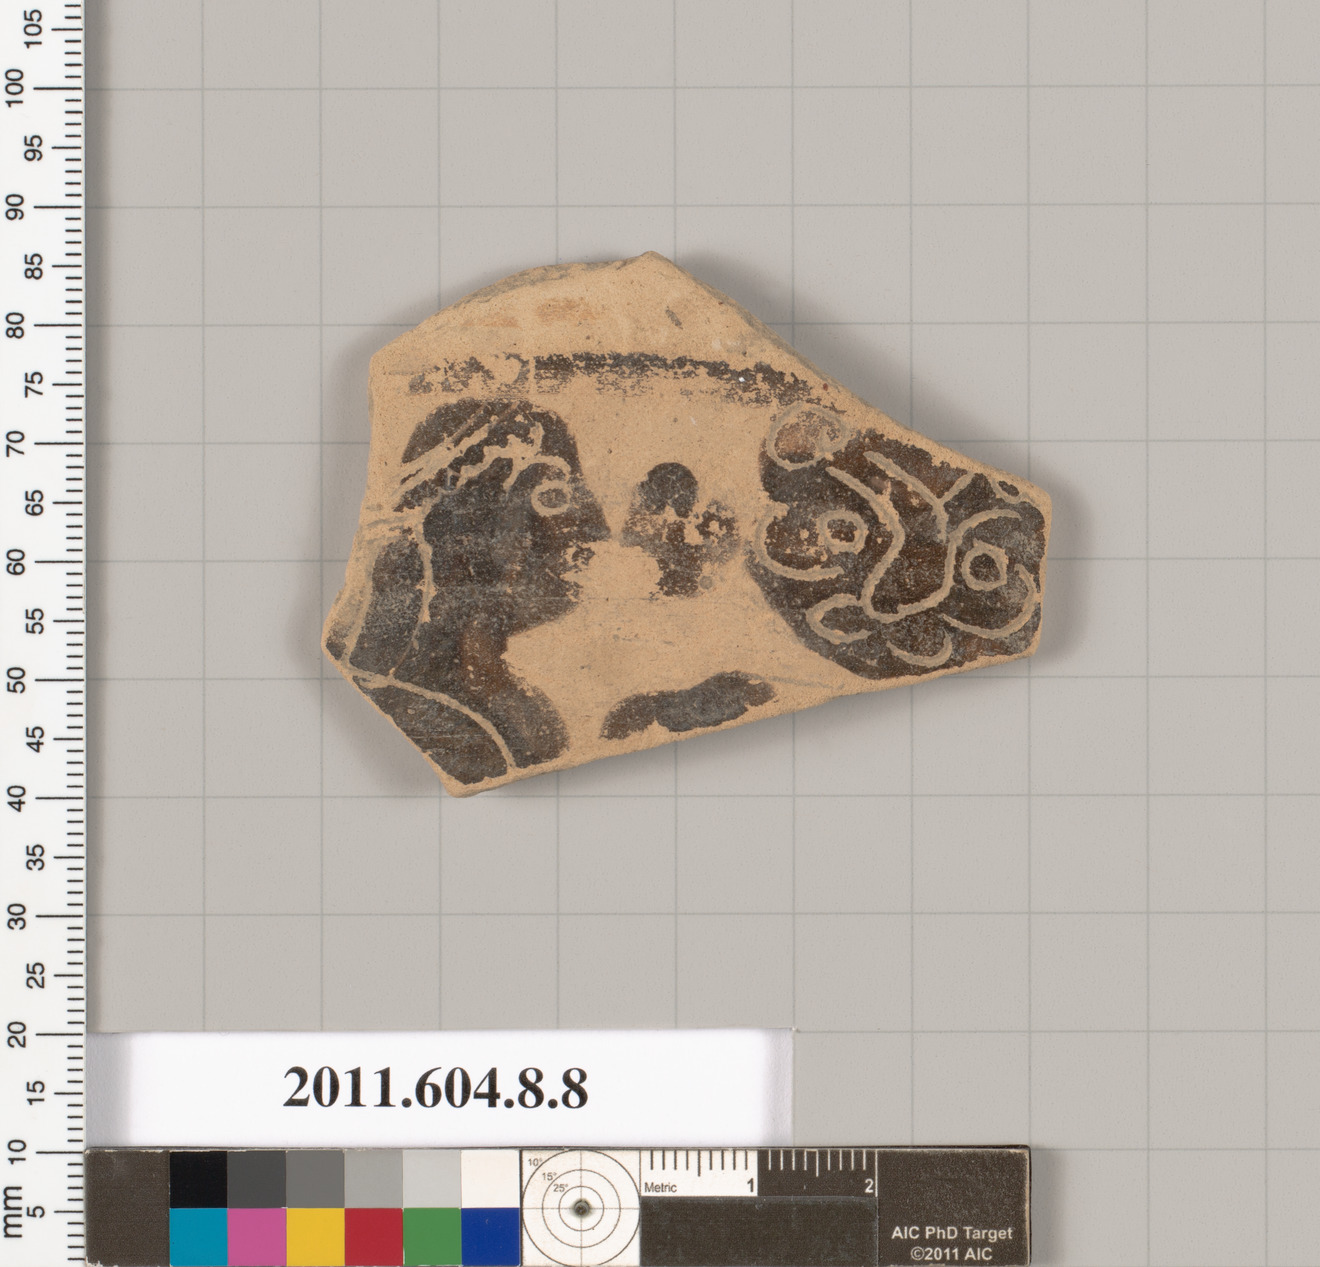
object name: skyphos fragment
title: Terracotta fragment of a skyphos?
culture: greek, corinthian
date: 600-501 BCE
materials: terracotta